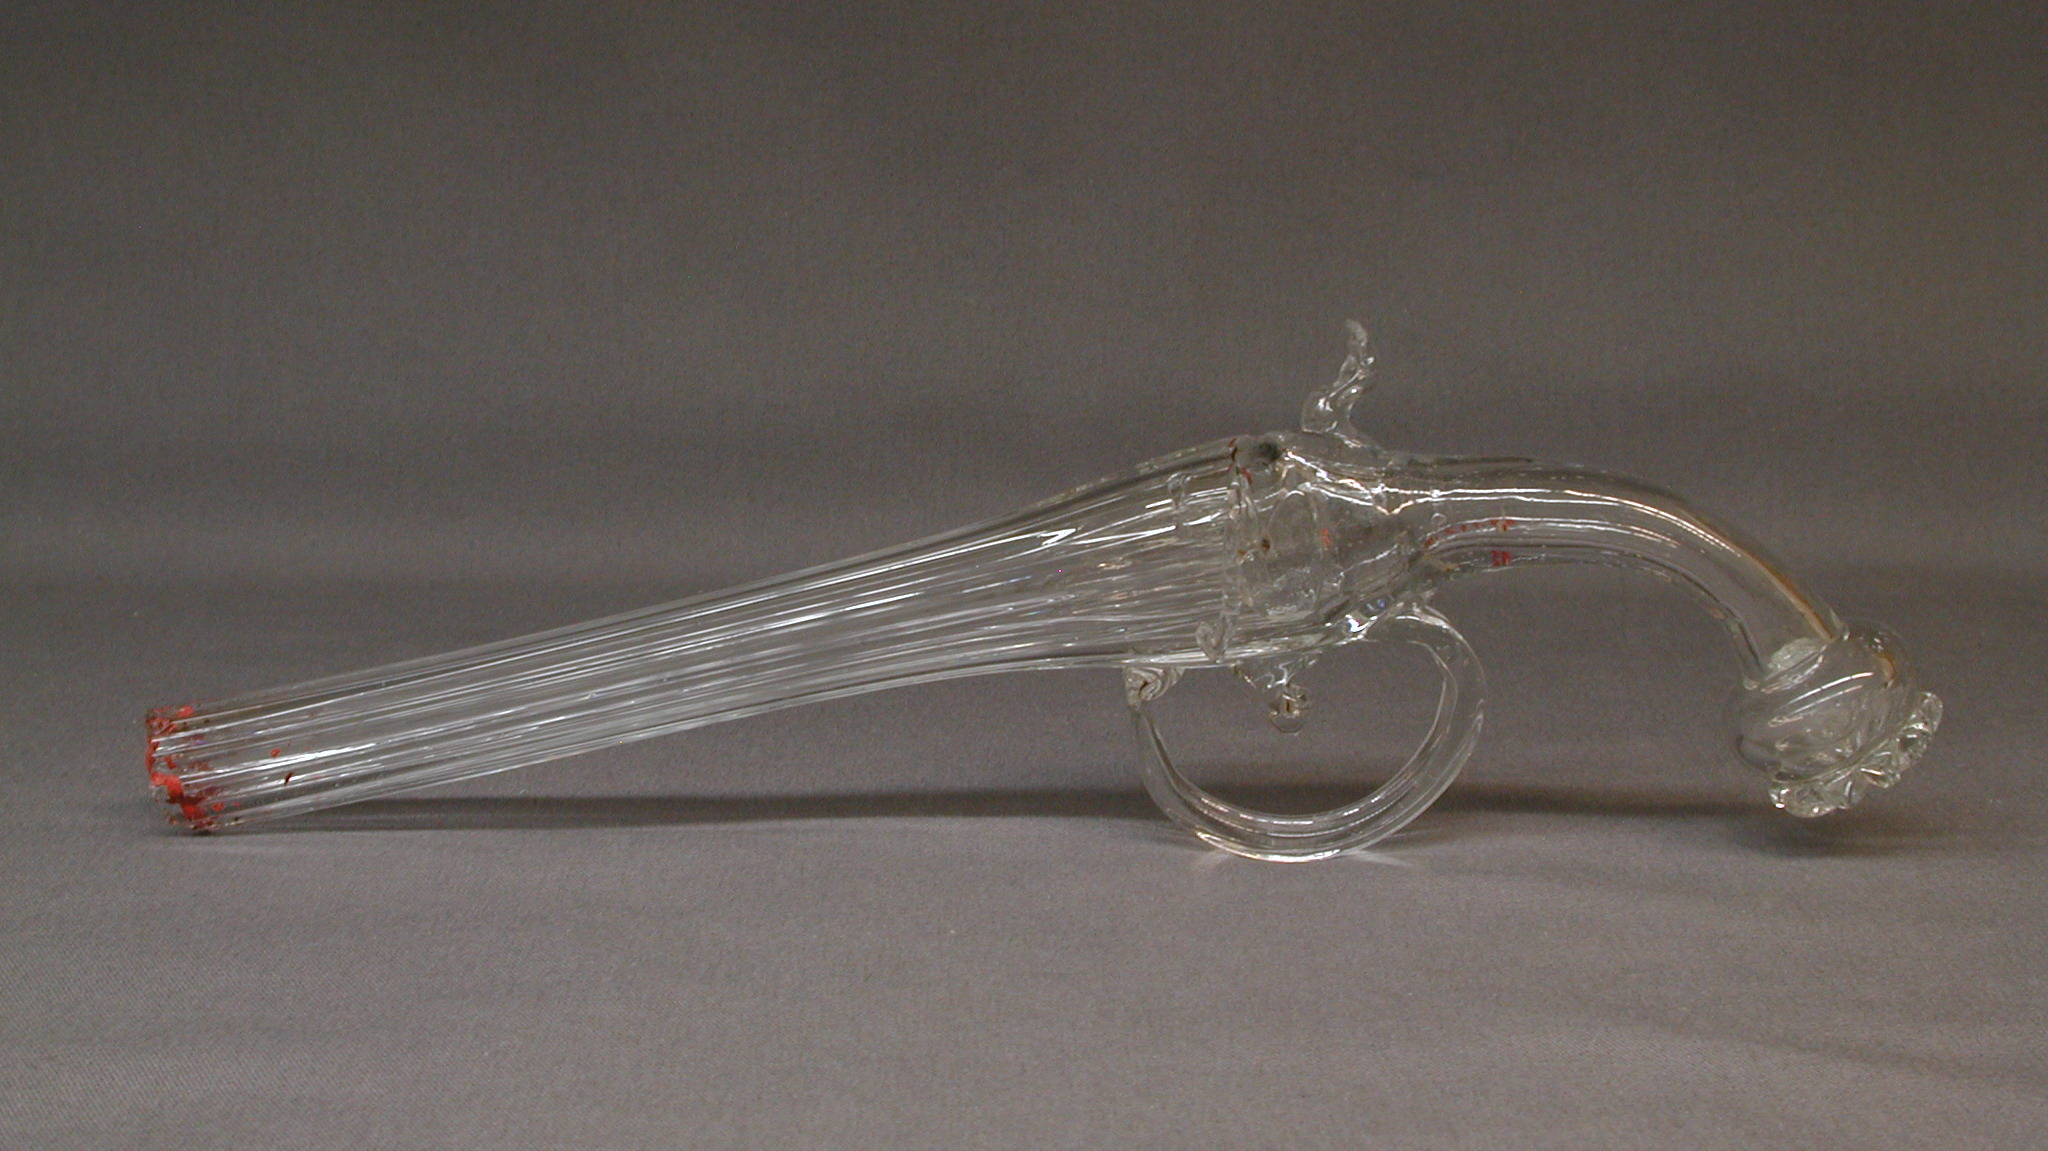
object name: pistol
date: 1601-1800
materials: glass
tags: firearms